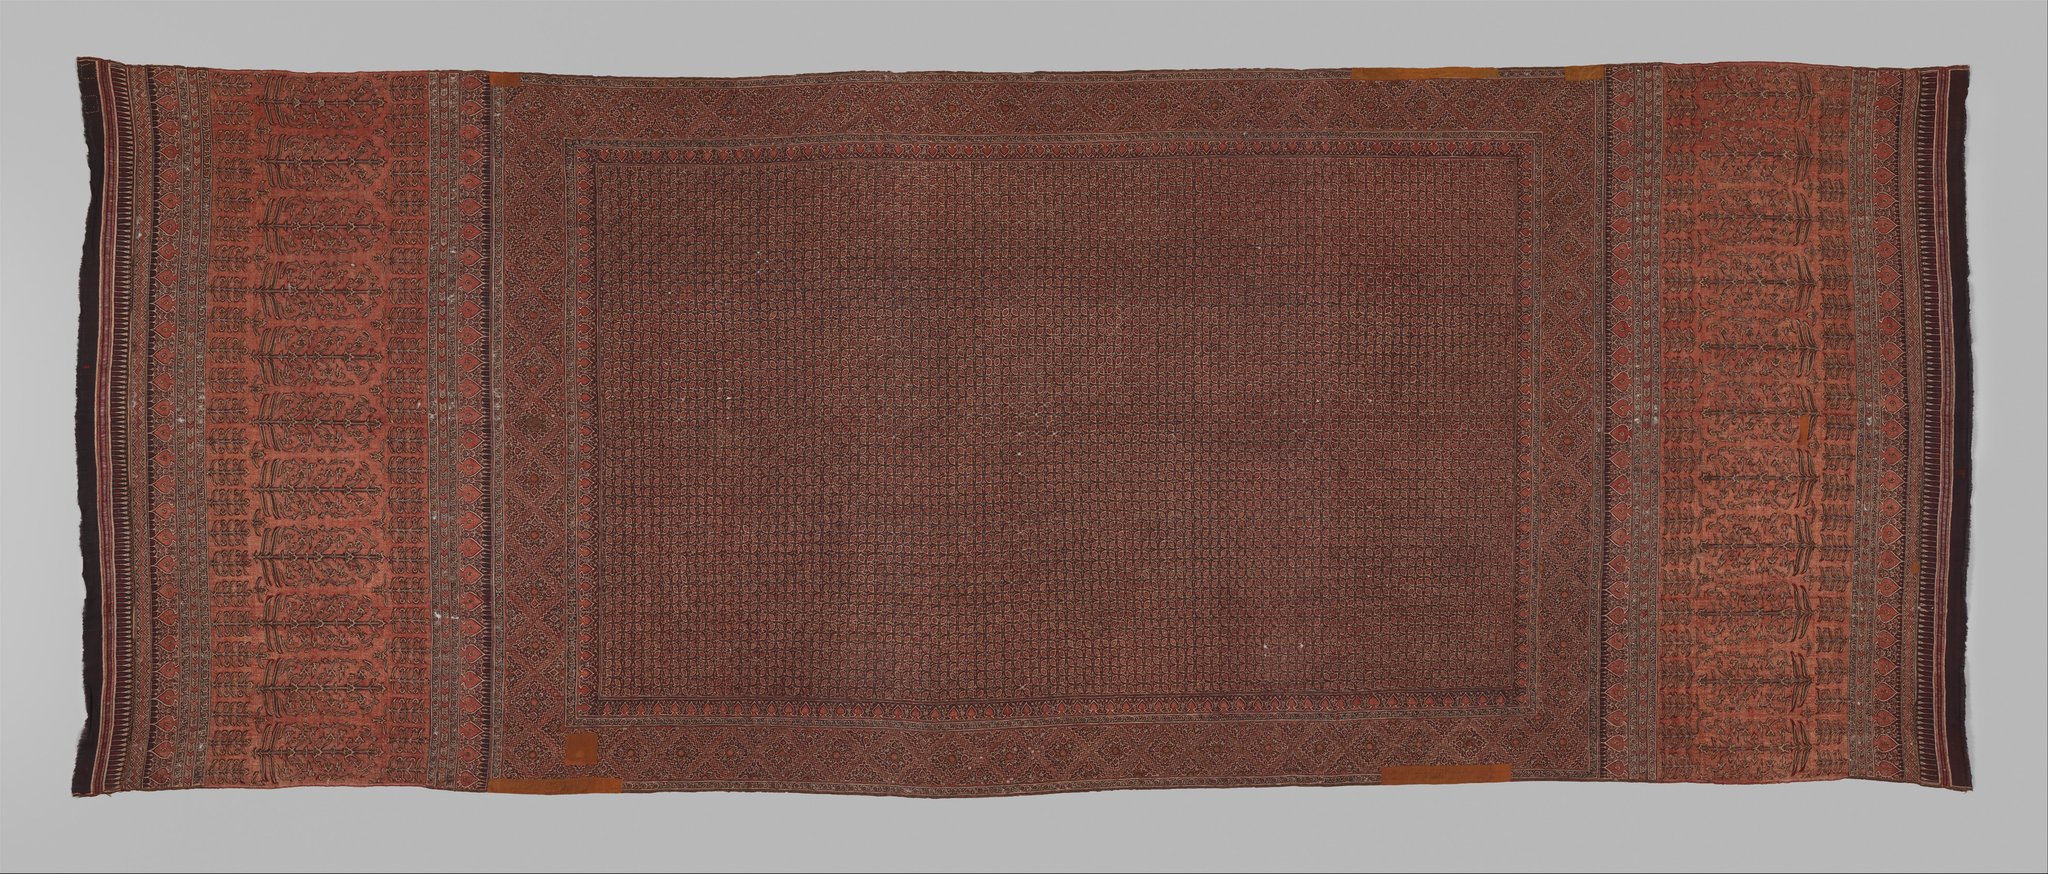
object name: shawl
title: Shawl (Chaddar)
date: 1601-1700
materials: cotton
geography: india